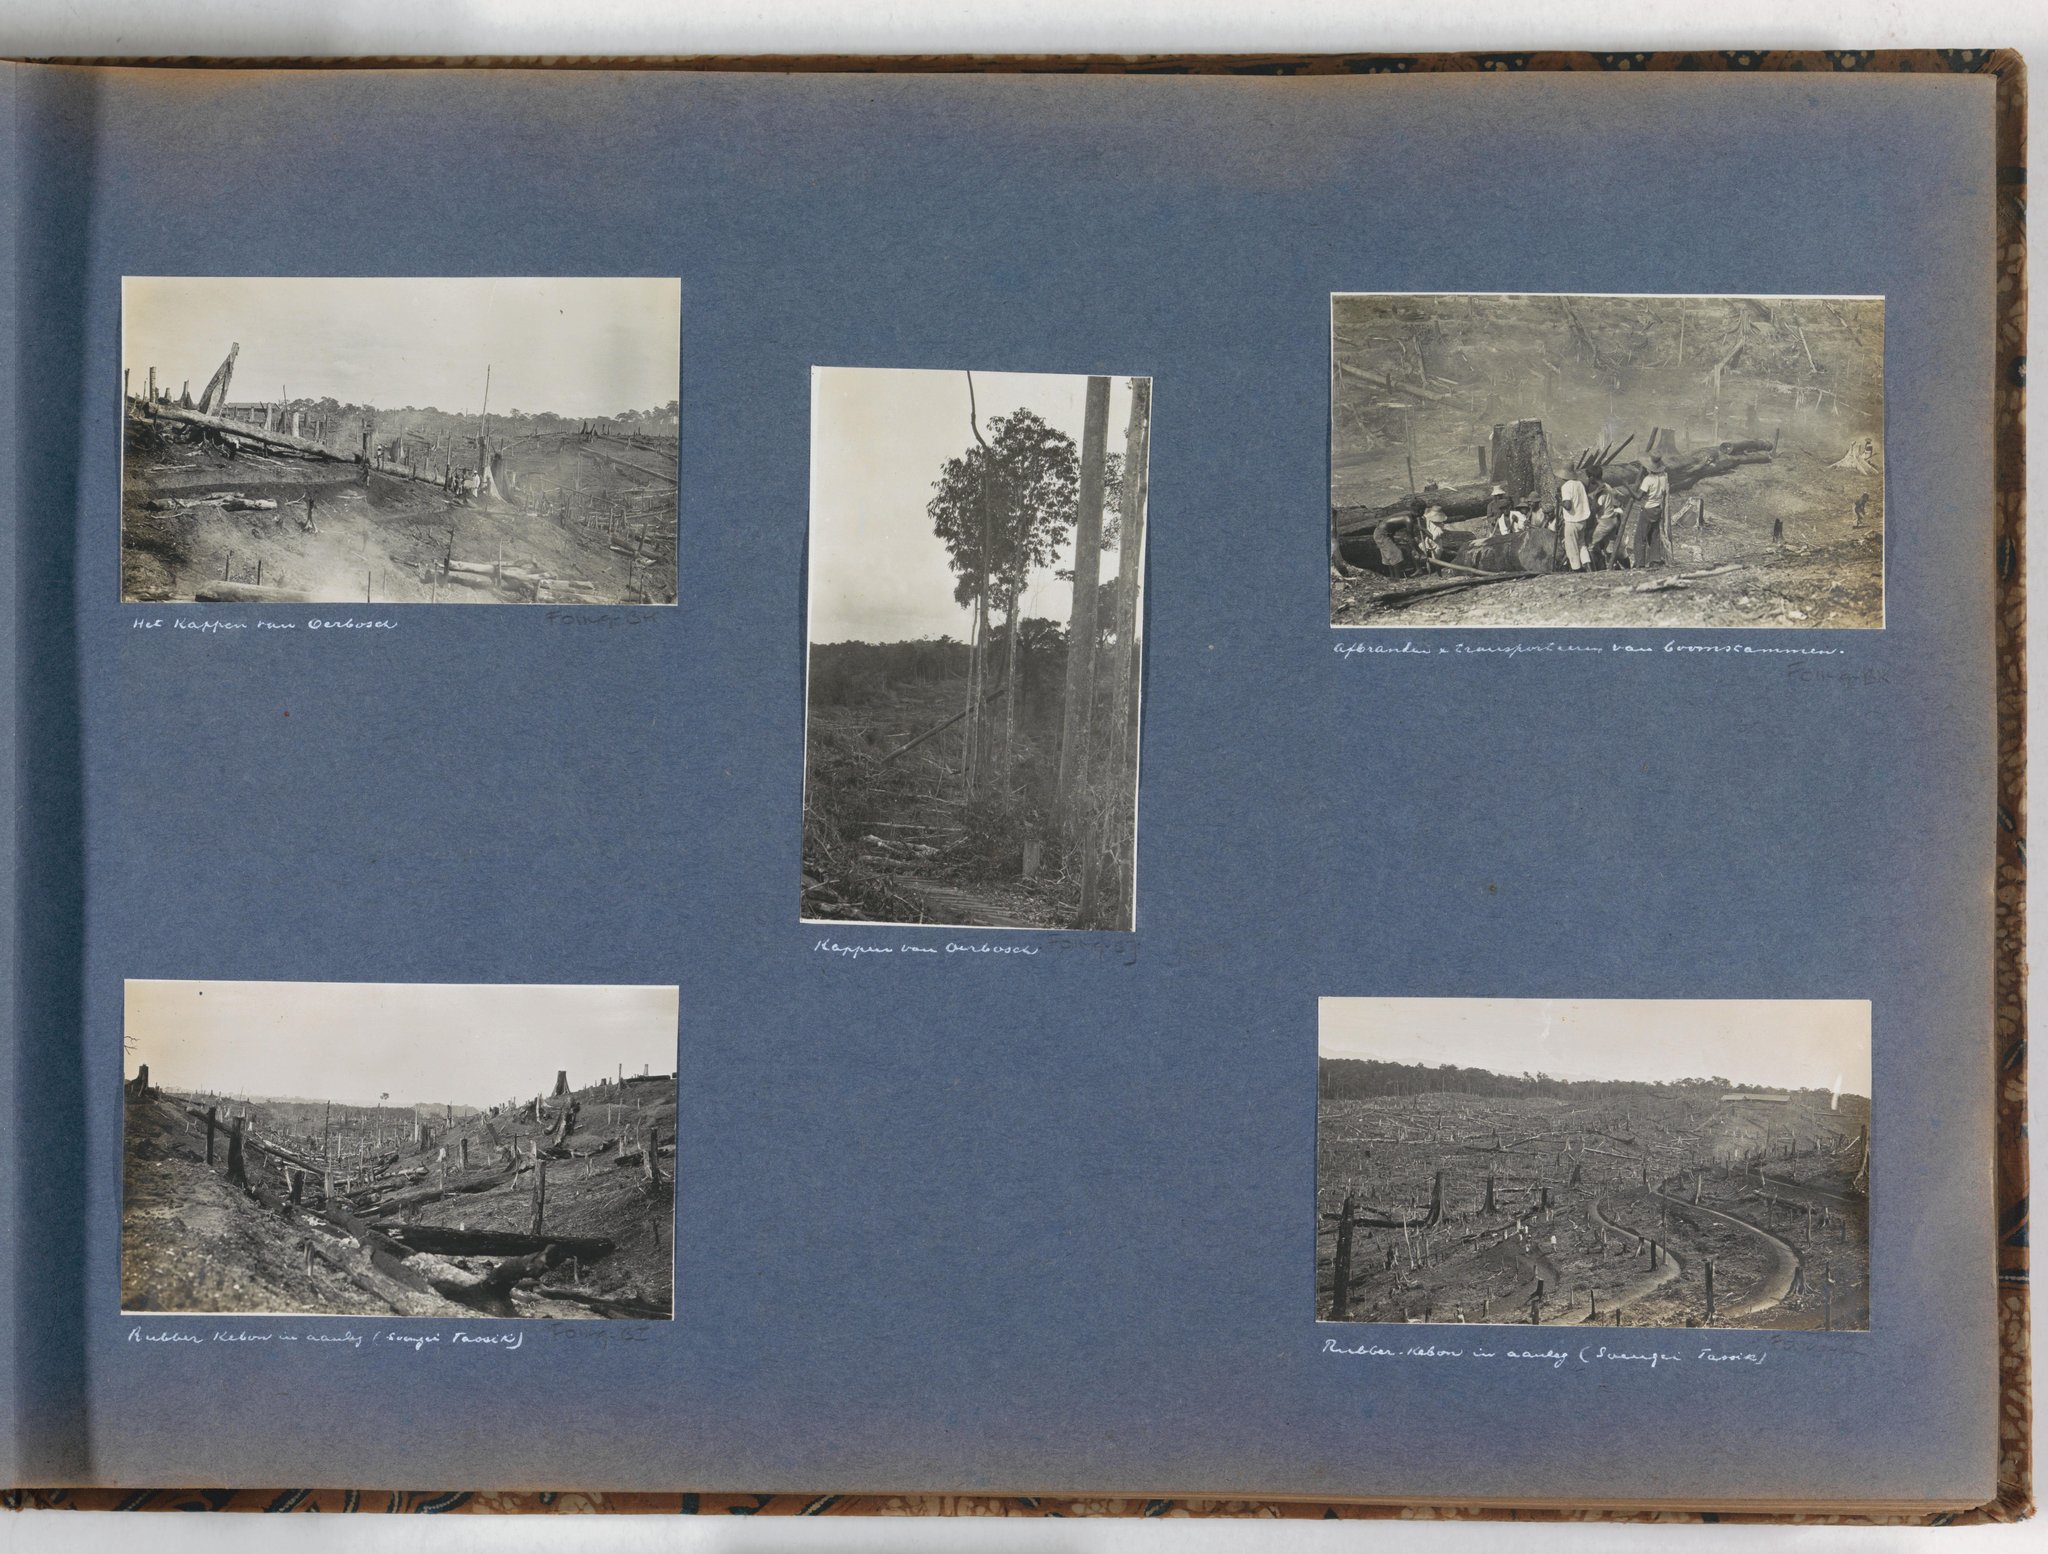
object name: album leaf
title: Aanleg van een rubberplantage van de Deli Maatschappij bij Soengei Tassik op Sumatra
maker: Anonymous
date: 1900-1920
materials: paper, photographic support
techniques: gelatin silver print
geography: sumatra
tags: plantation, (non-fruit) products of plants or trees: rubber, sumatra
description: Onderdeel van reisalbum met foto's van bedrijvigheid en bezienswaardigheden op Sumatra en Java en van de reis naar en van Nederlands-Indië.